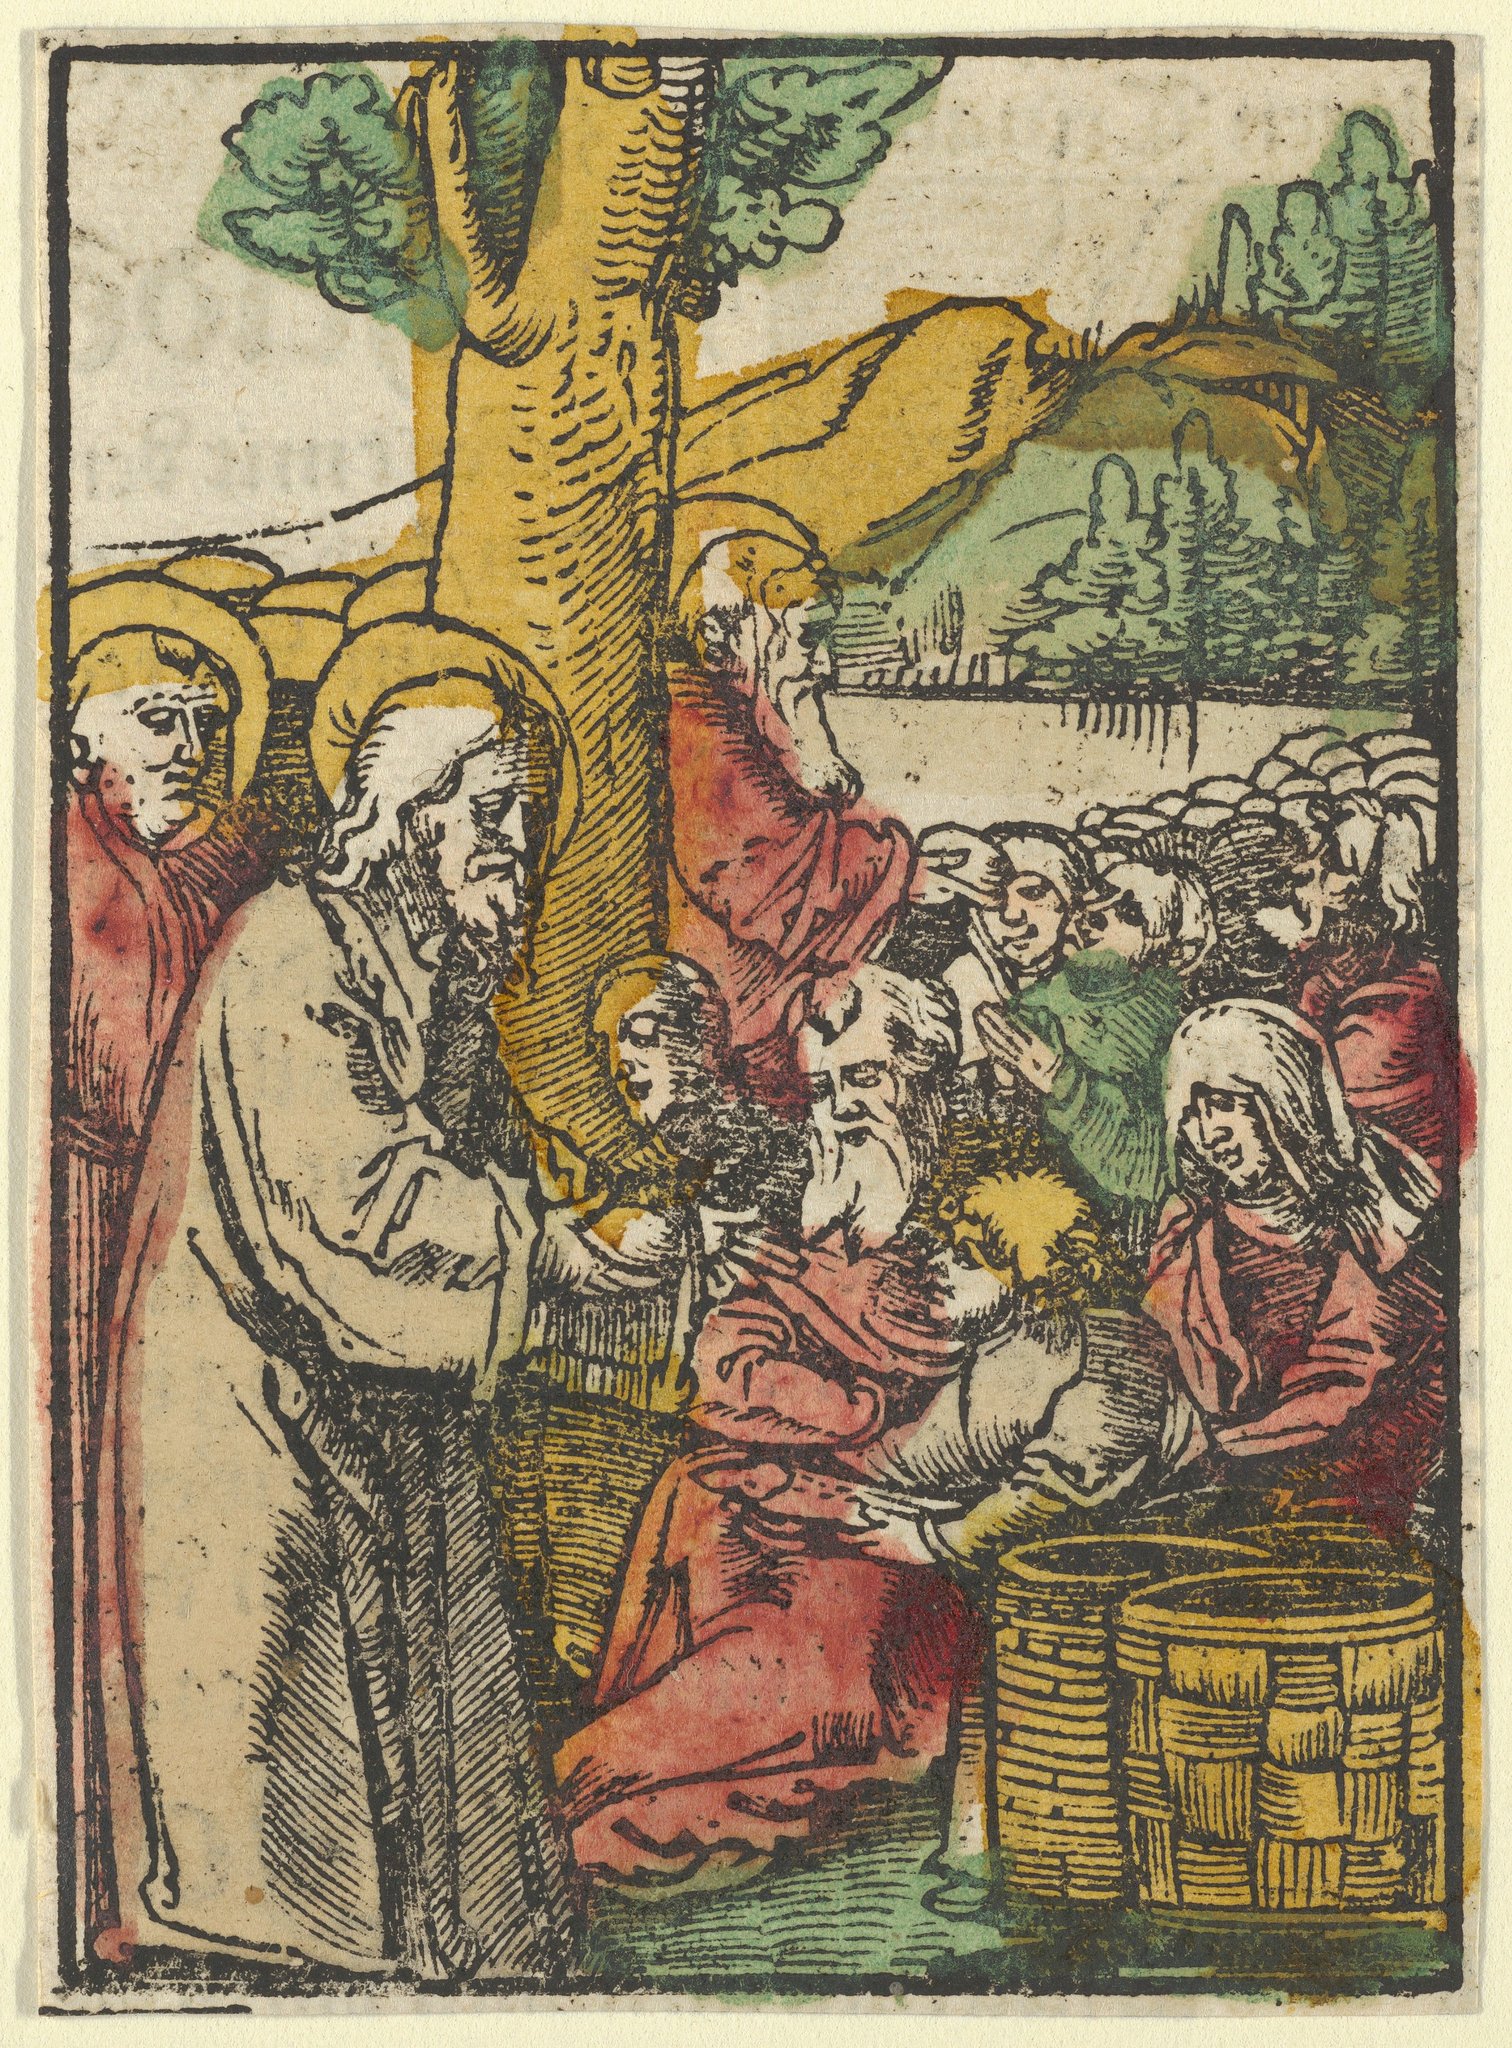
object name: print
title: The Feeding of the 5000, from Das Plenarium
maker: hans schäufelein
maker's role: artist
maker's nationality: german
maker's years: 1480-1540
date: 1517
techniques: hand coloring, woodcut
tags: men,women,jesus